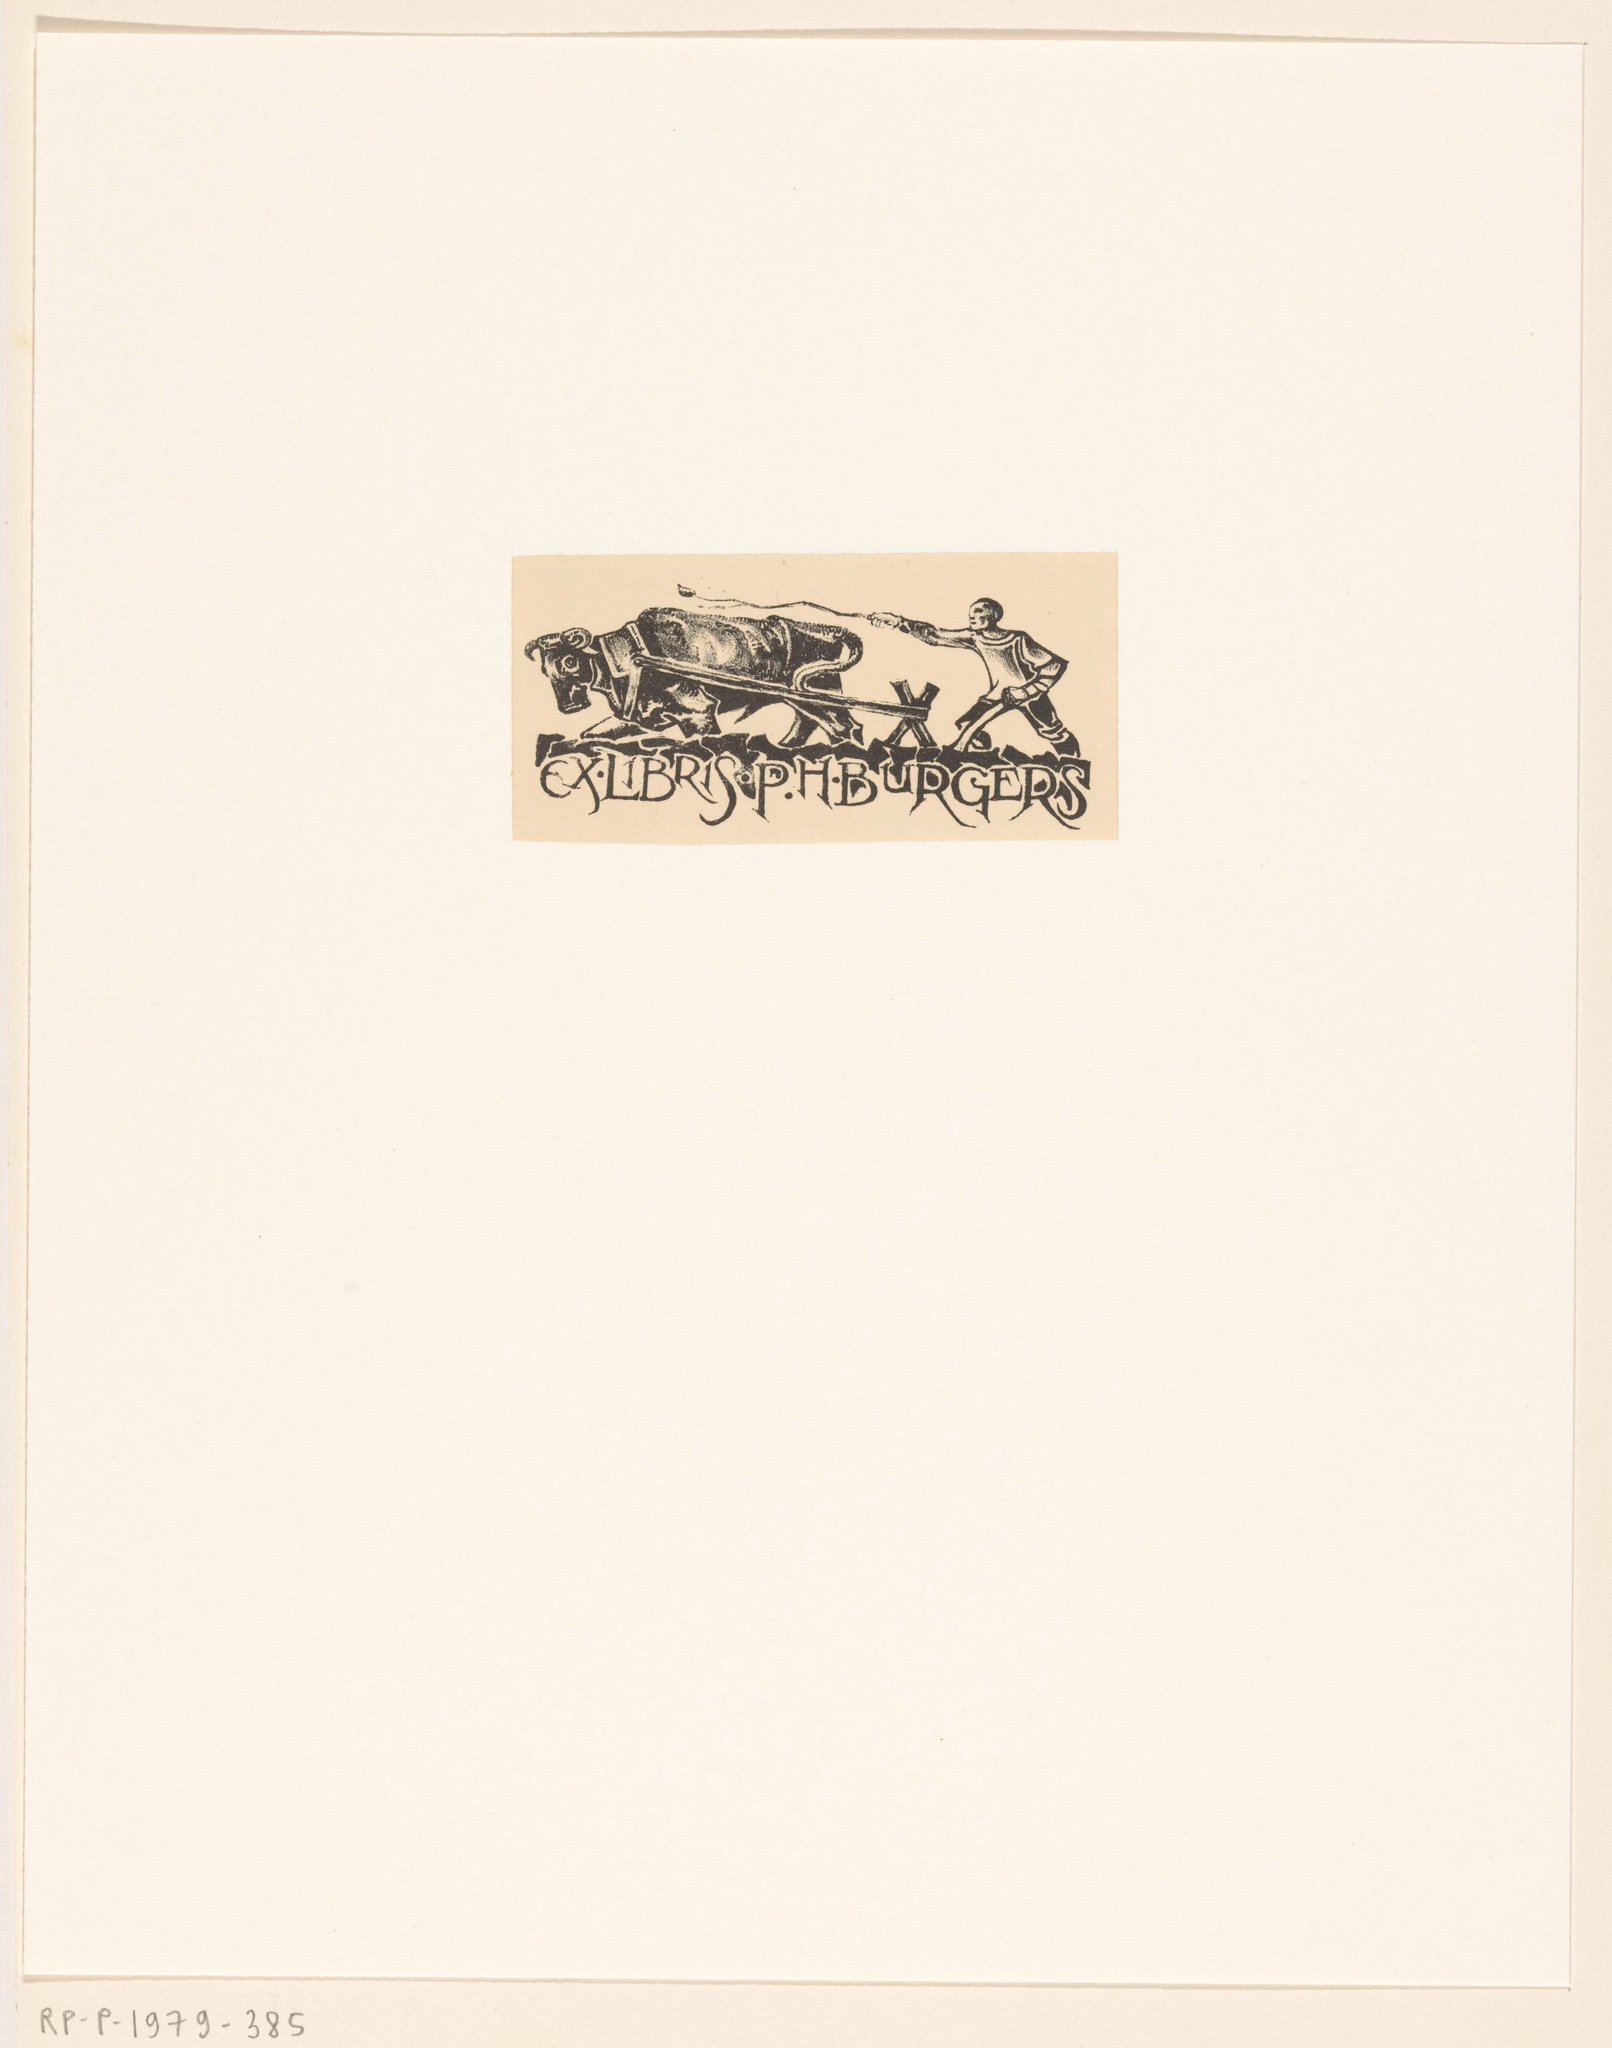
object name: print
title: Ex libris van P.H. Burgers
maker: richard nicolaüs roland holst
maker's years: 1868-1938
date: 1925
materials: paper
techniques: lithograph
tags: politician, ox, ploughing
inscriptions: collector's mark: Lugt 2228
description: Dit ex libris was vermoedelijk bestemd voor Petrus Burgers, de echtgenoot van Sabine Roland Holst, die een zus was van Richard Roland Holst.